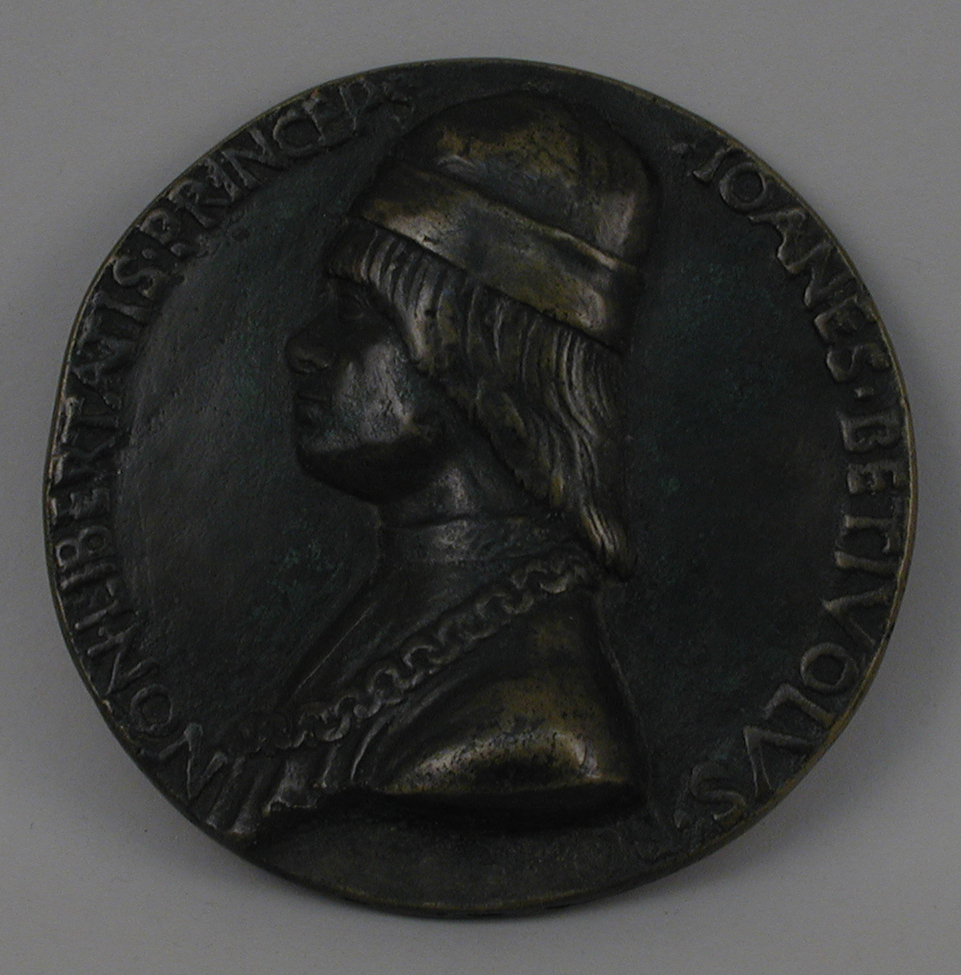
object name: medal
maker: savelli sperandio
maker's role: artist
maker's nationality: italian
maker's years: 1425-1504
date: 1450-1499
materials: bronze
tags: men,profiles